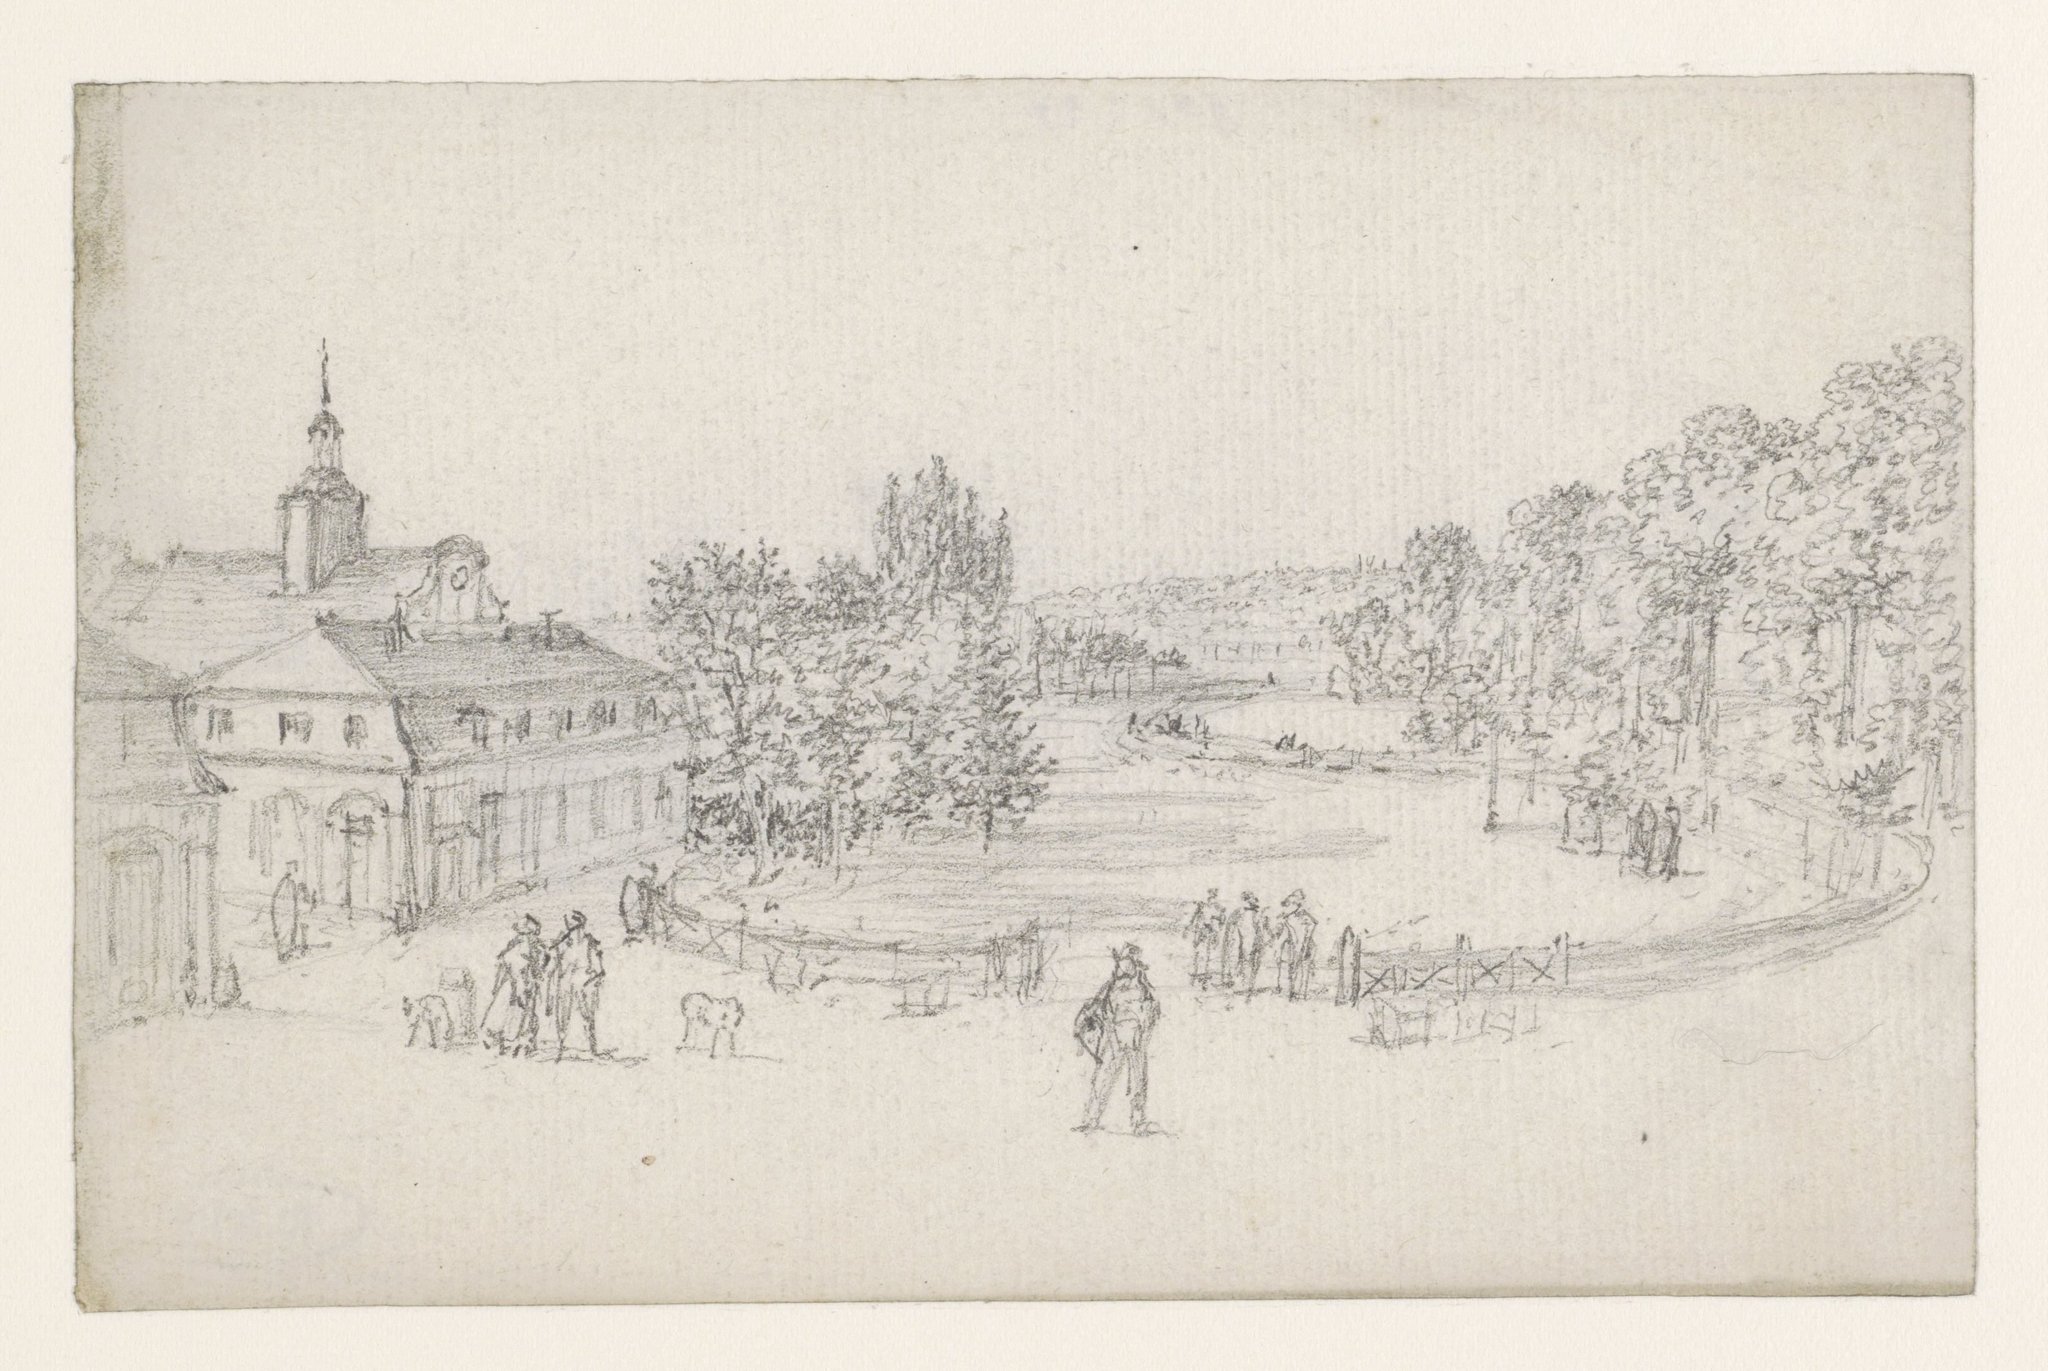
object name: drawing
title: Saint Cloud (?)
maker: georges michel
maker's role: draughtsman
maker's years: 1763-1843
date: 1773-1843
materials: paper, pencil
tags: square, place, circus, etc. (+ city(-scape) with figures, staffage)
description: Een van 120 tekeningen, afkomstig uit een 19e eeuws album met tekeningen van Georges Michel.